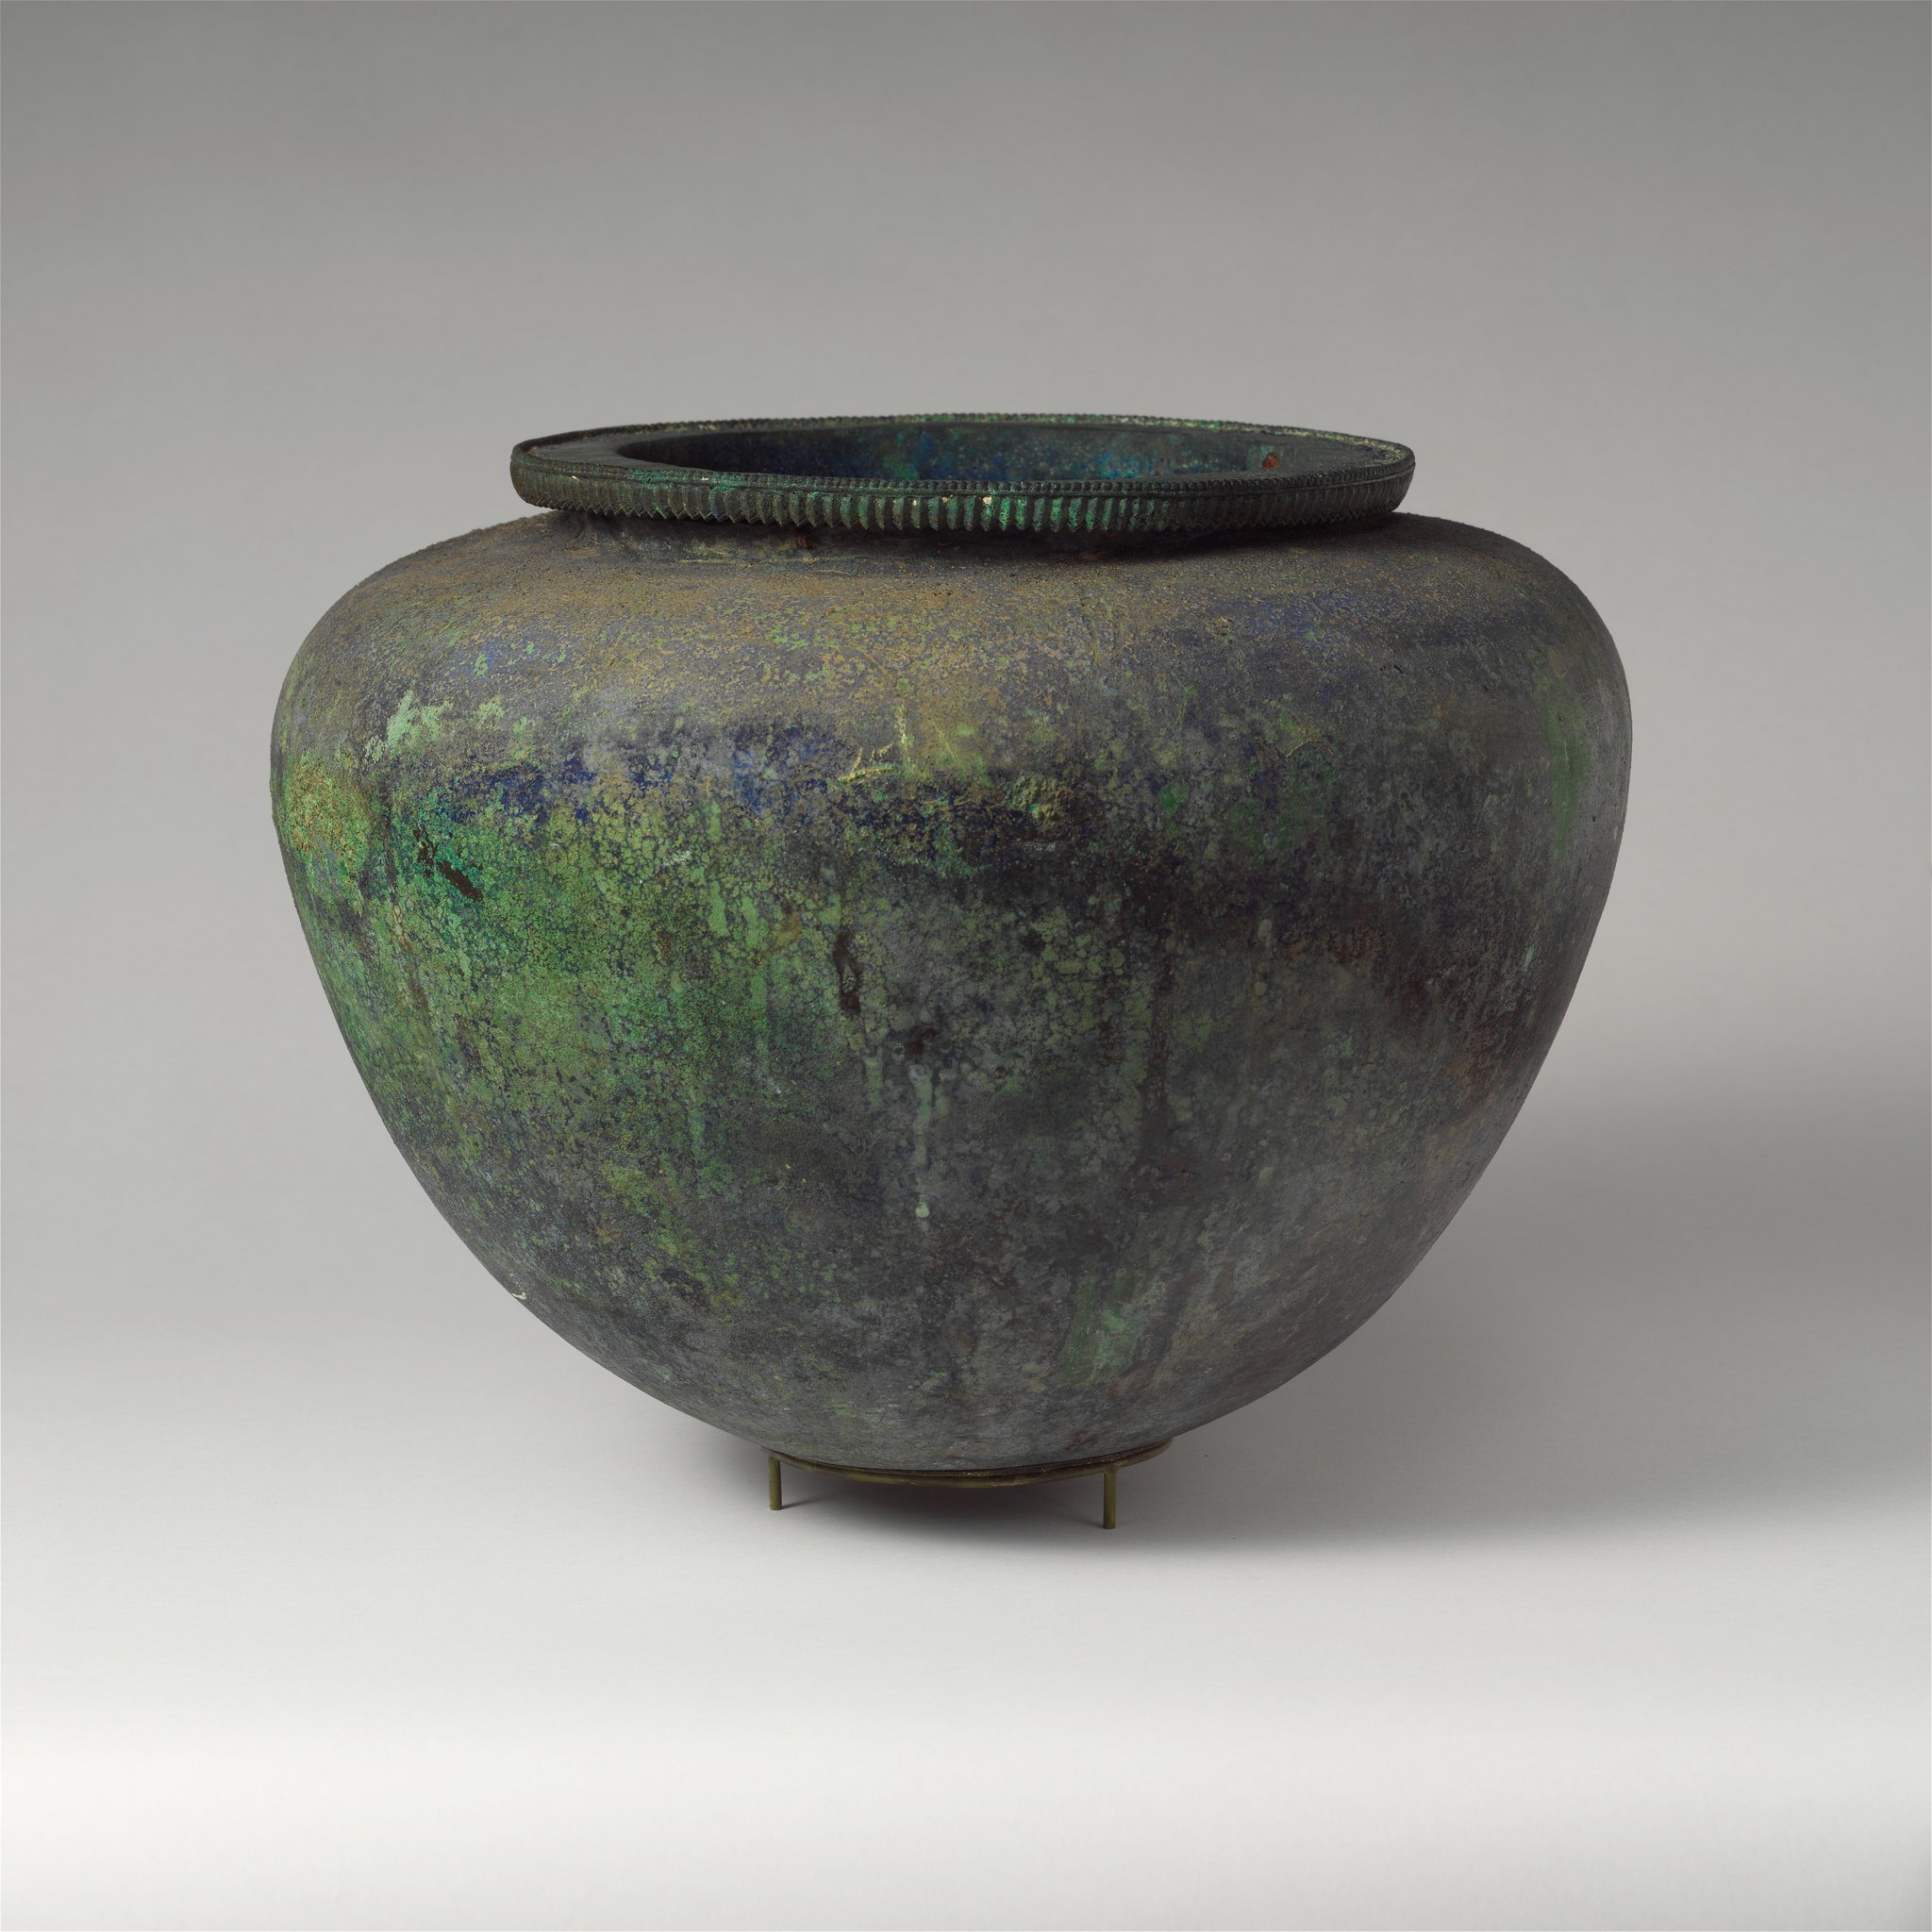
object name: cauldron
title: Bronze cauldron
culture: greek or south italian or campanian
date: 500-401 BCE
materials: bronze